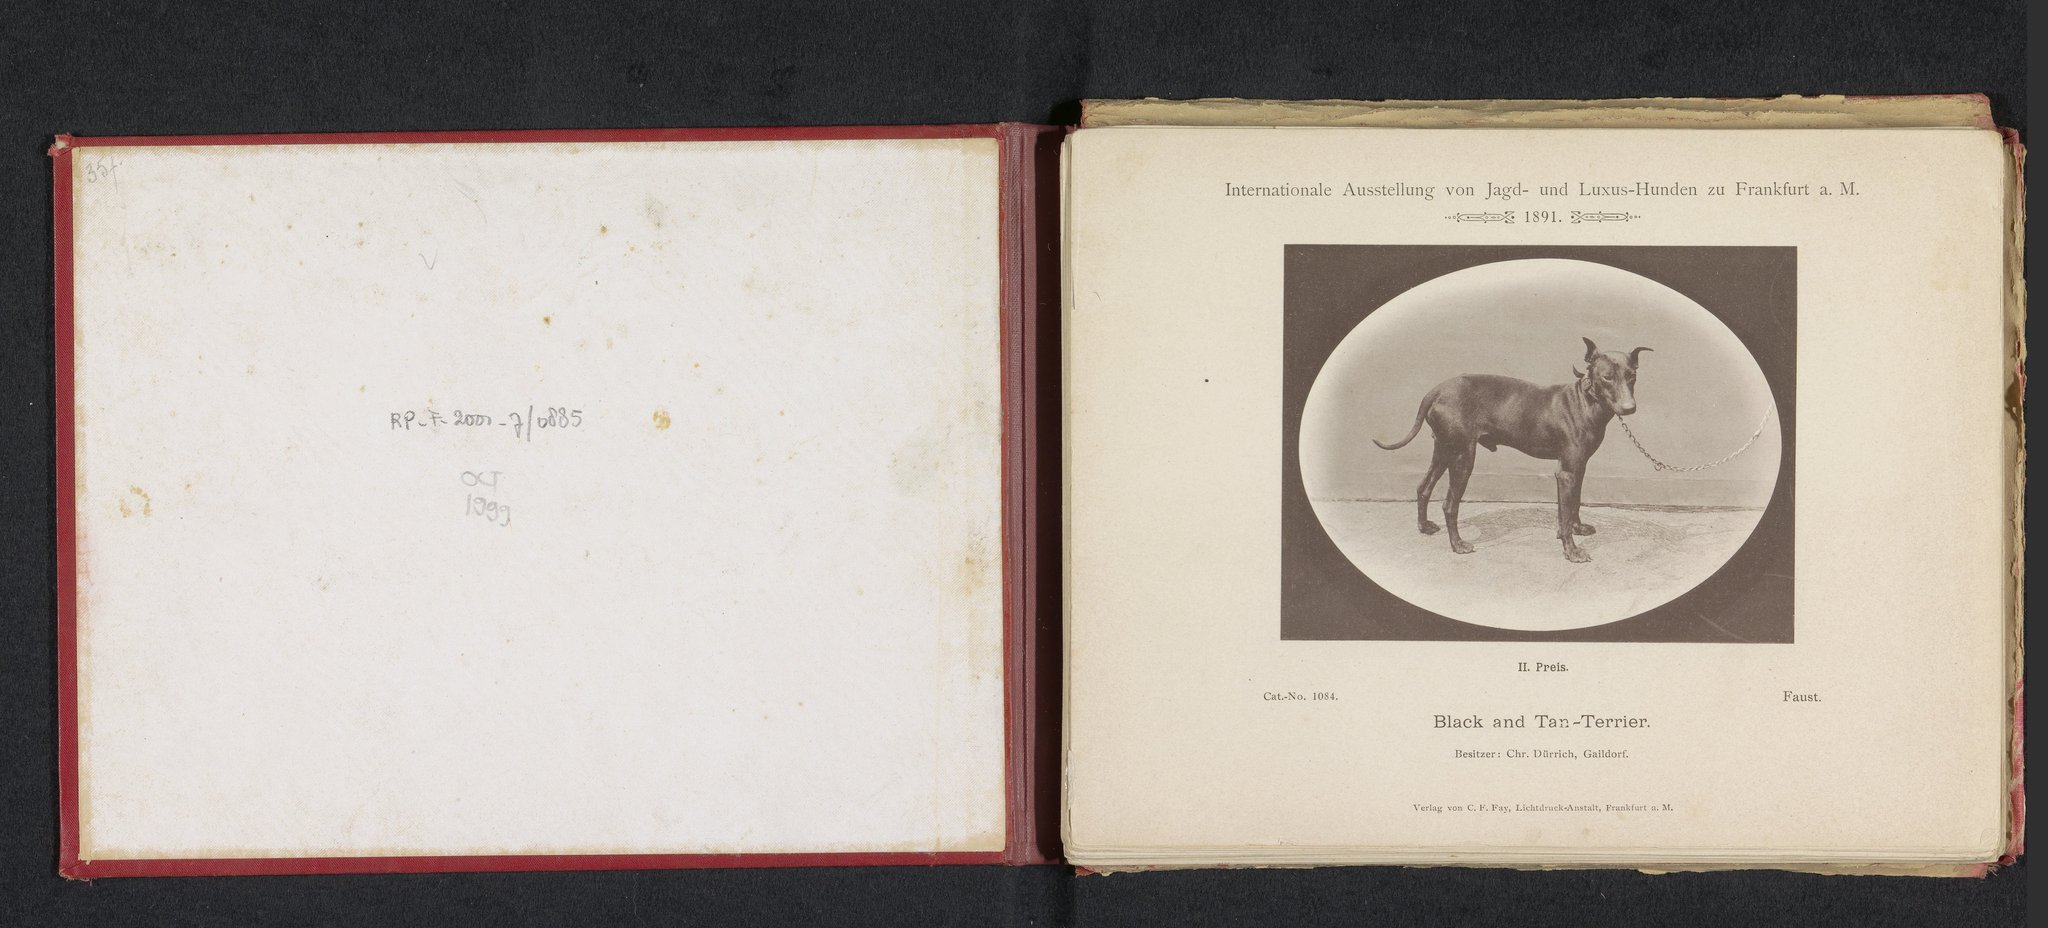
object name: page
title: Black and Tan-Terrier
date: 1891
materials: paper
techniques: photograph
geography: frankfurt am main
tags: dog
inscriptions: inscription: ‘II. Preis. Faust. Besitzer : Chr. Dürrich, Gaildorf.’, number: ‘Cat.-No. 1084.’